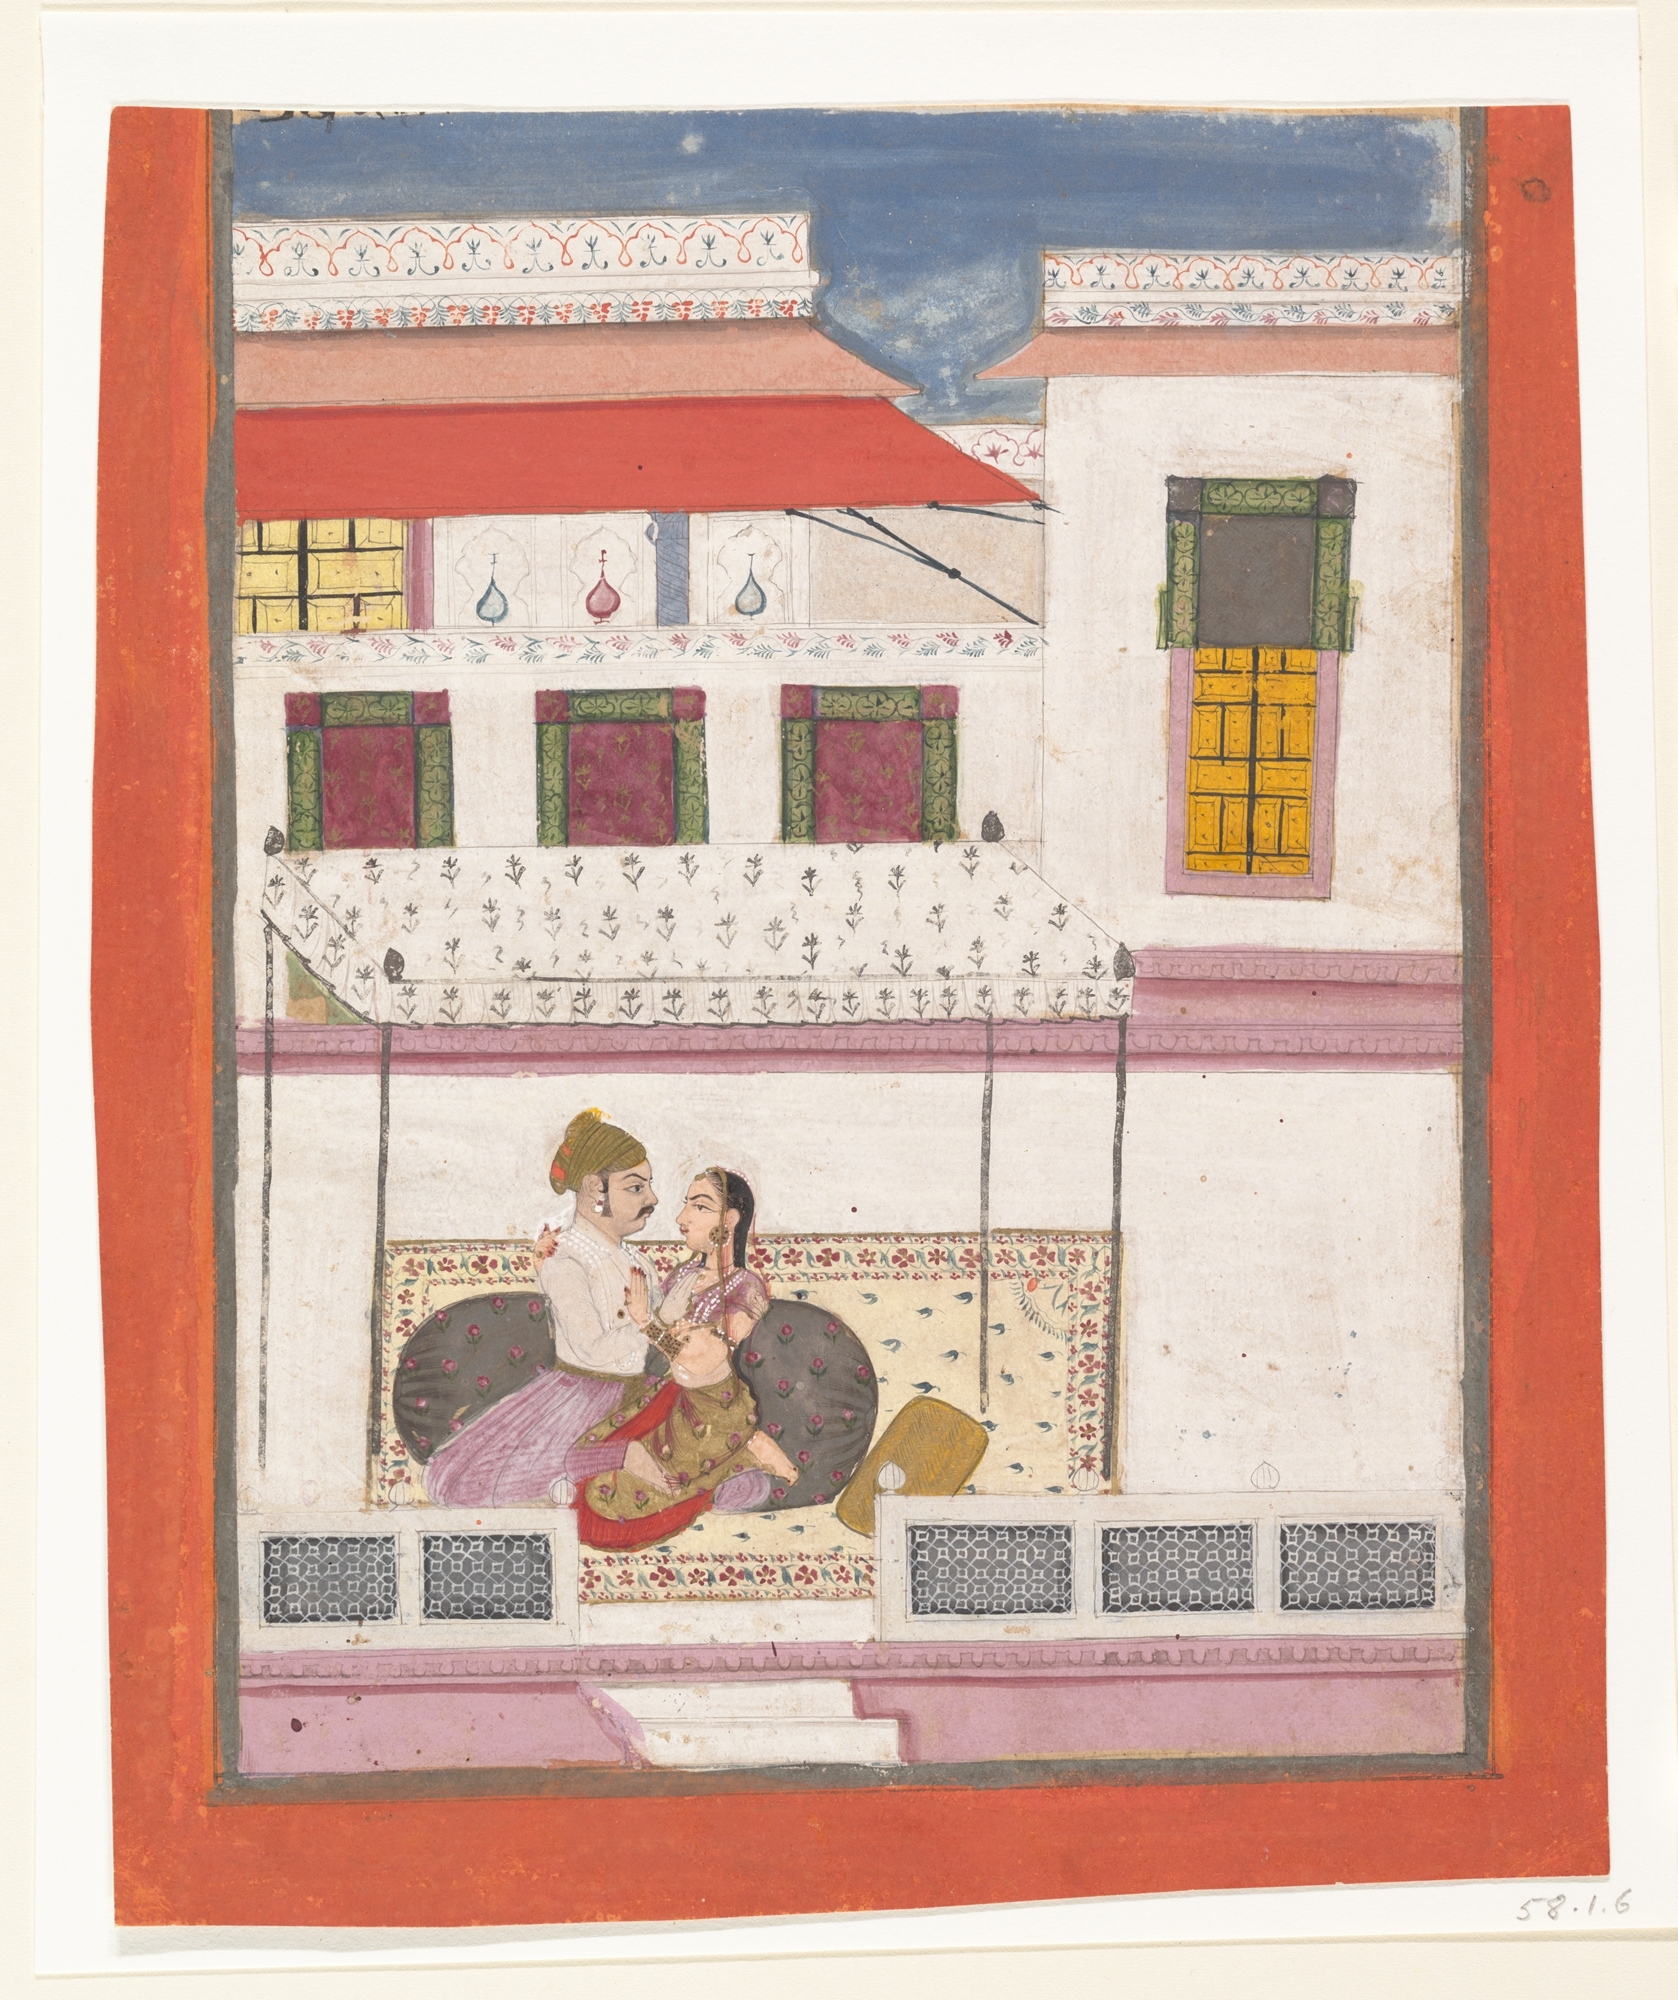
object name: folio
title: Raga Desakar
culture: indian or rajasthan or amber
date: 1701-1733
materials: gilt, ink, paper, watercolor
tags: men,women